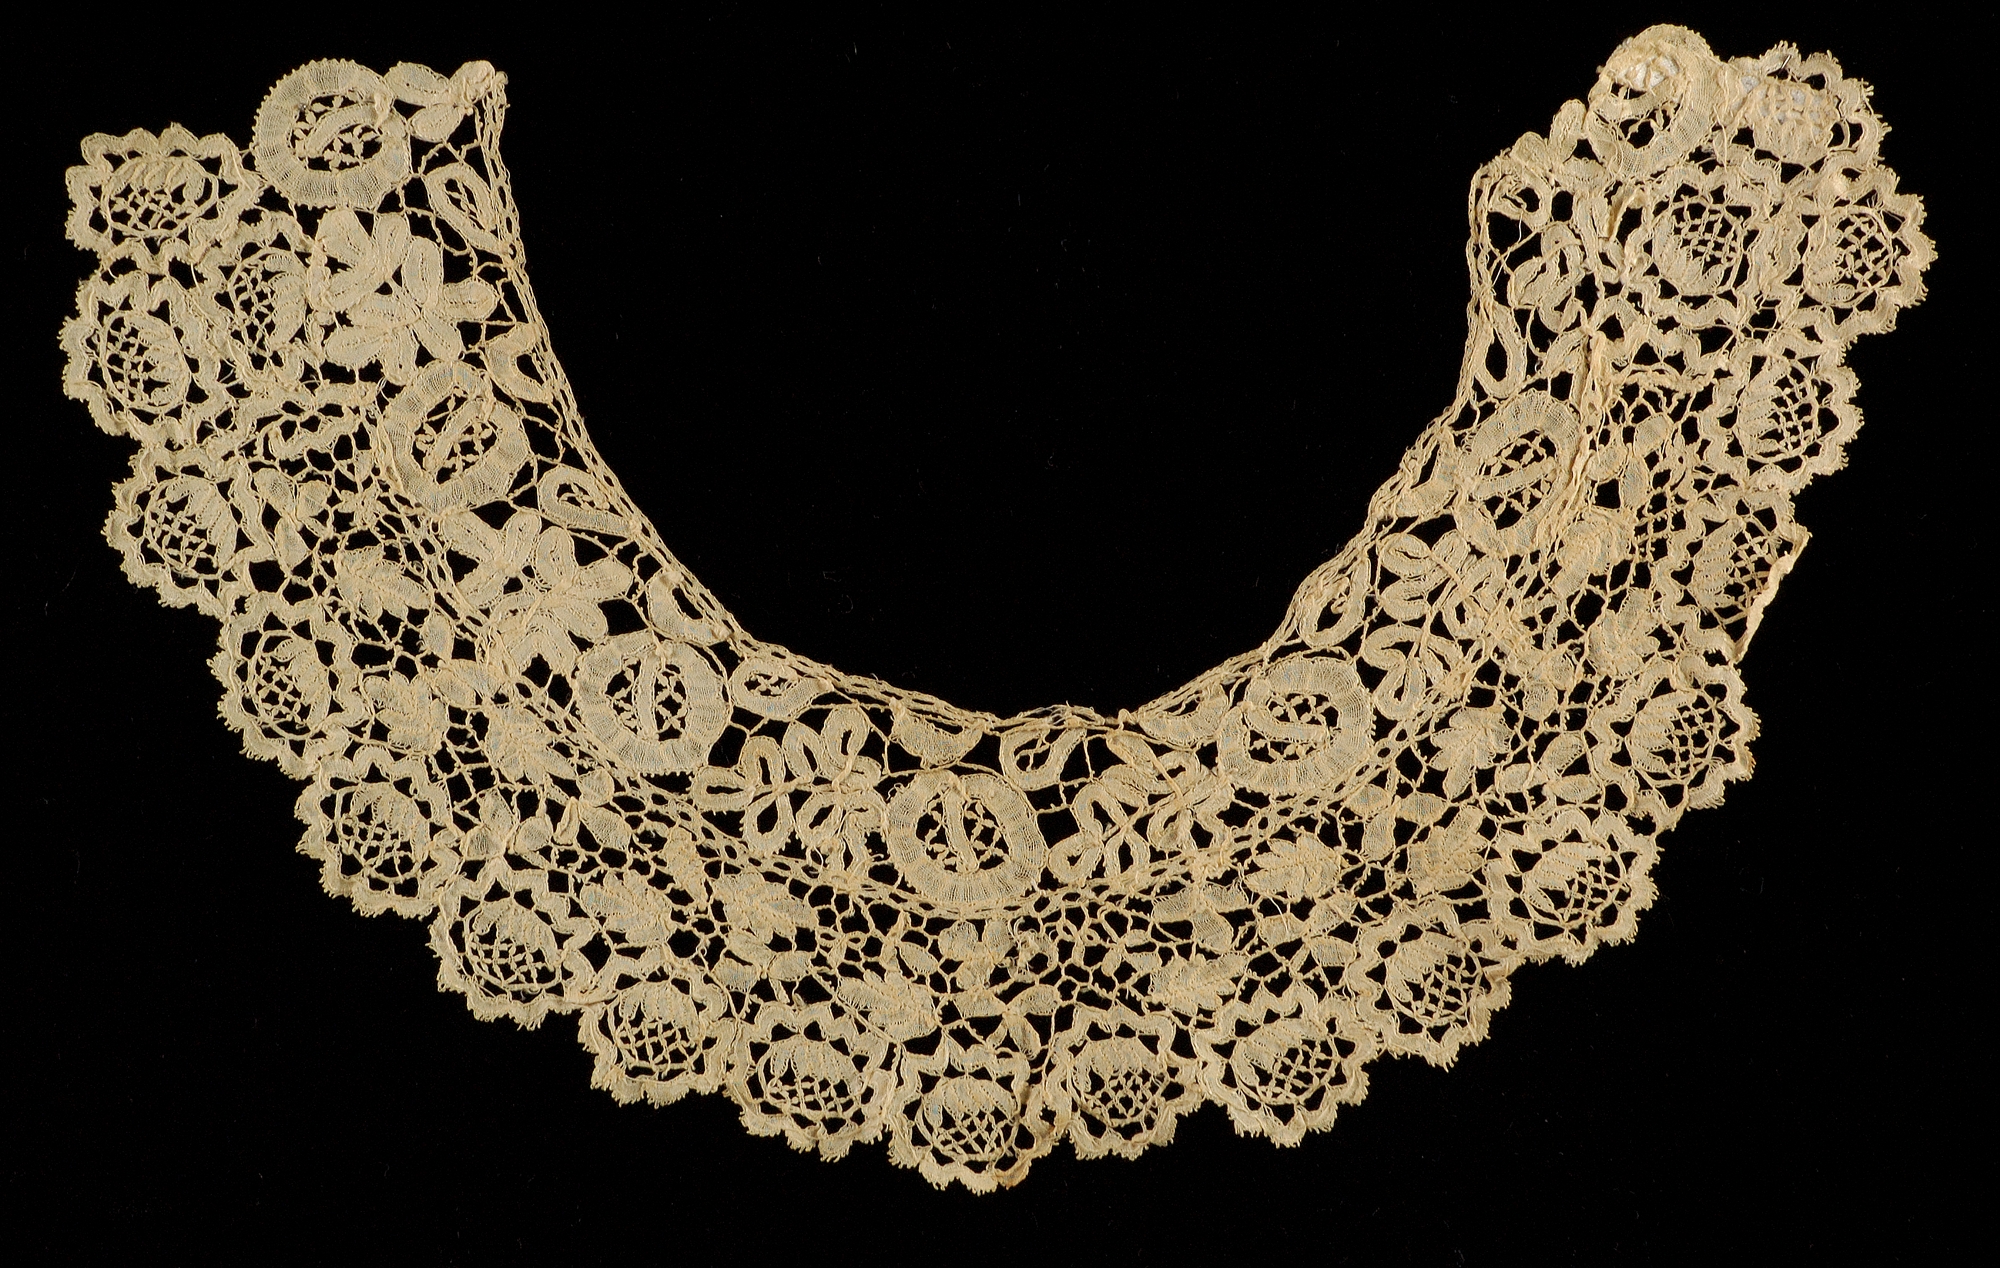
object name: collar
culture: british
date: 1860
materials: linen